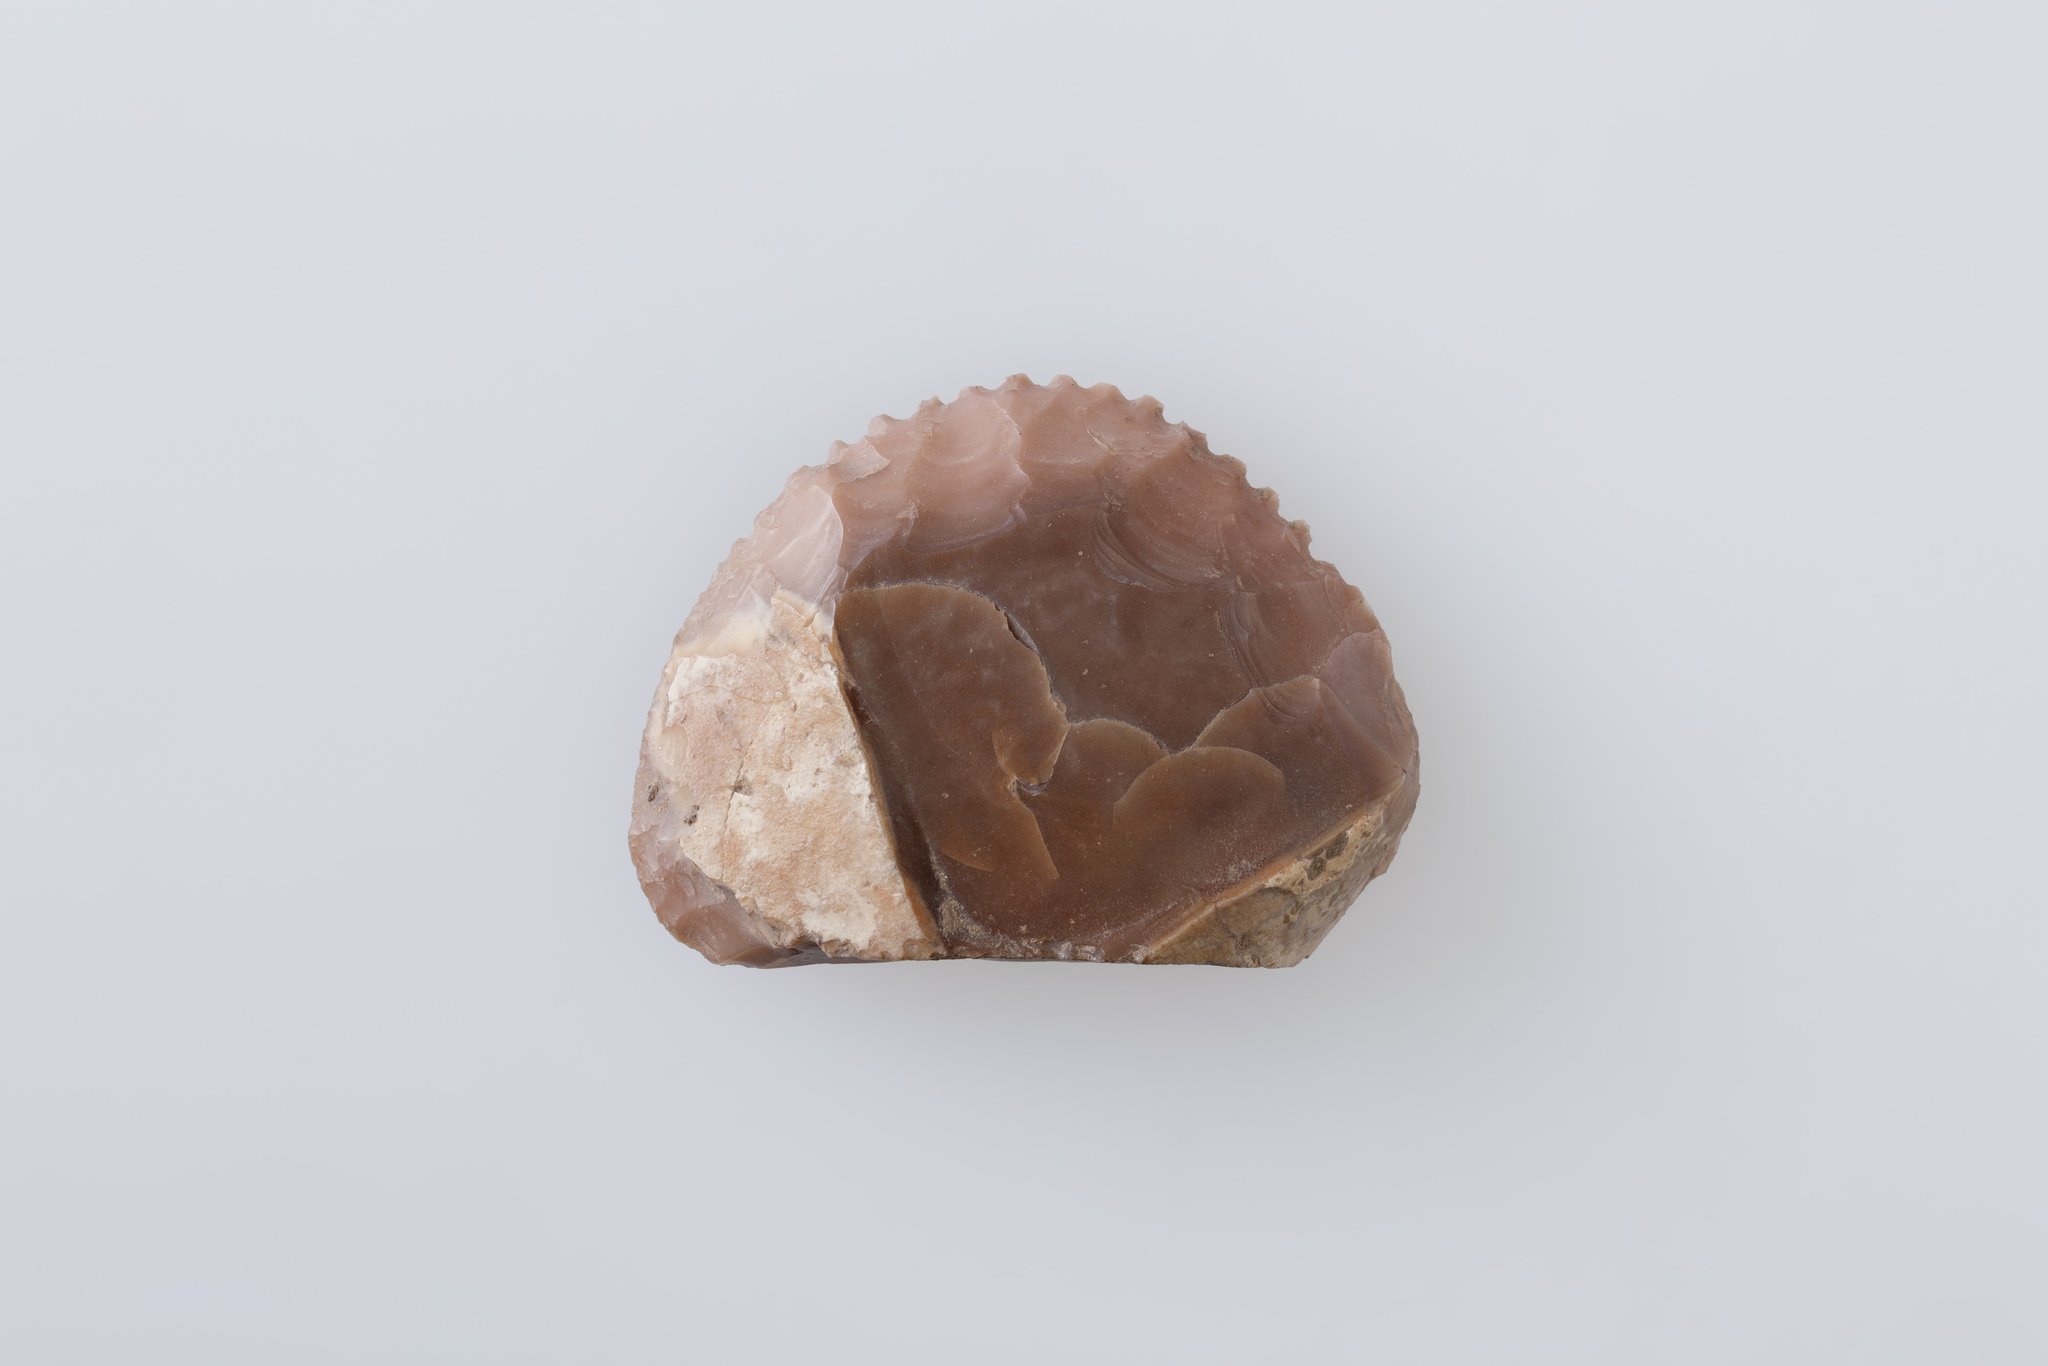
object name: tool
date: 3100-2649 BCE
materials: stone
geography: egypt